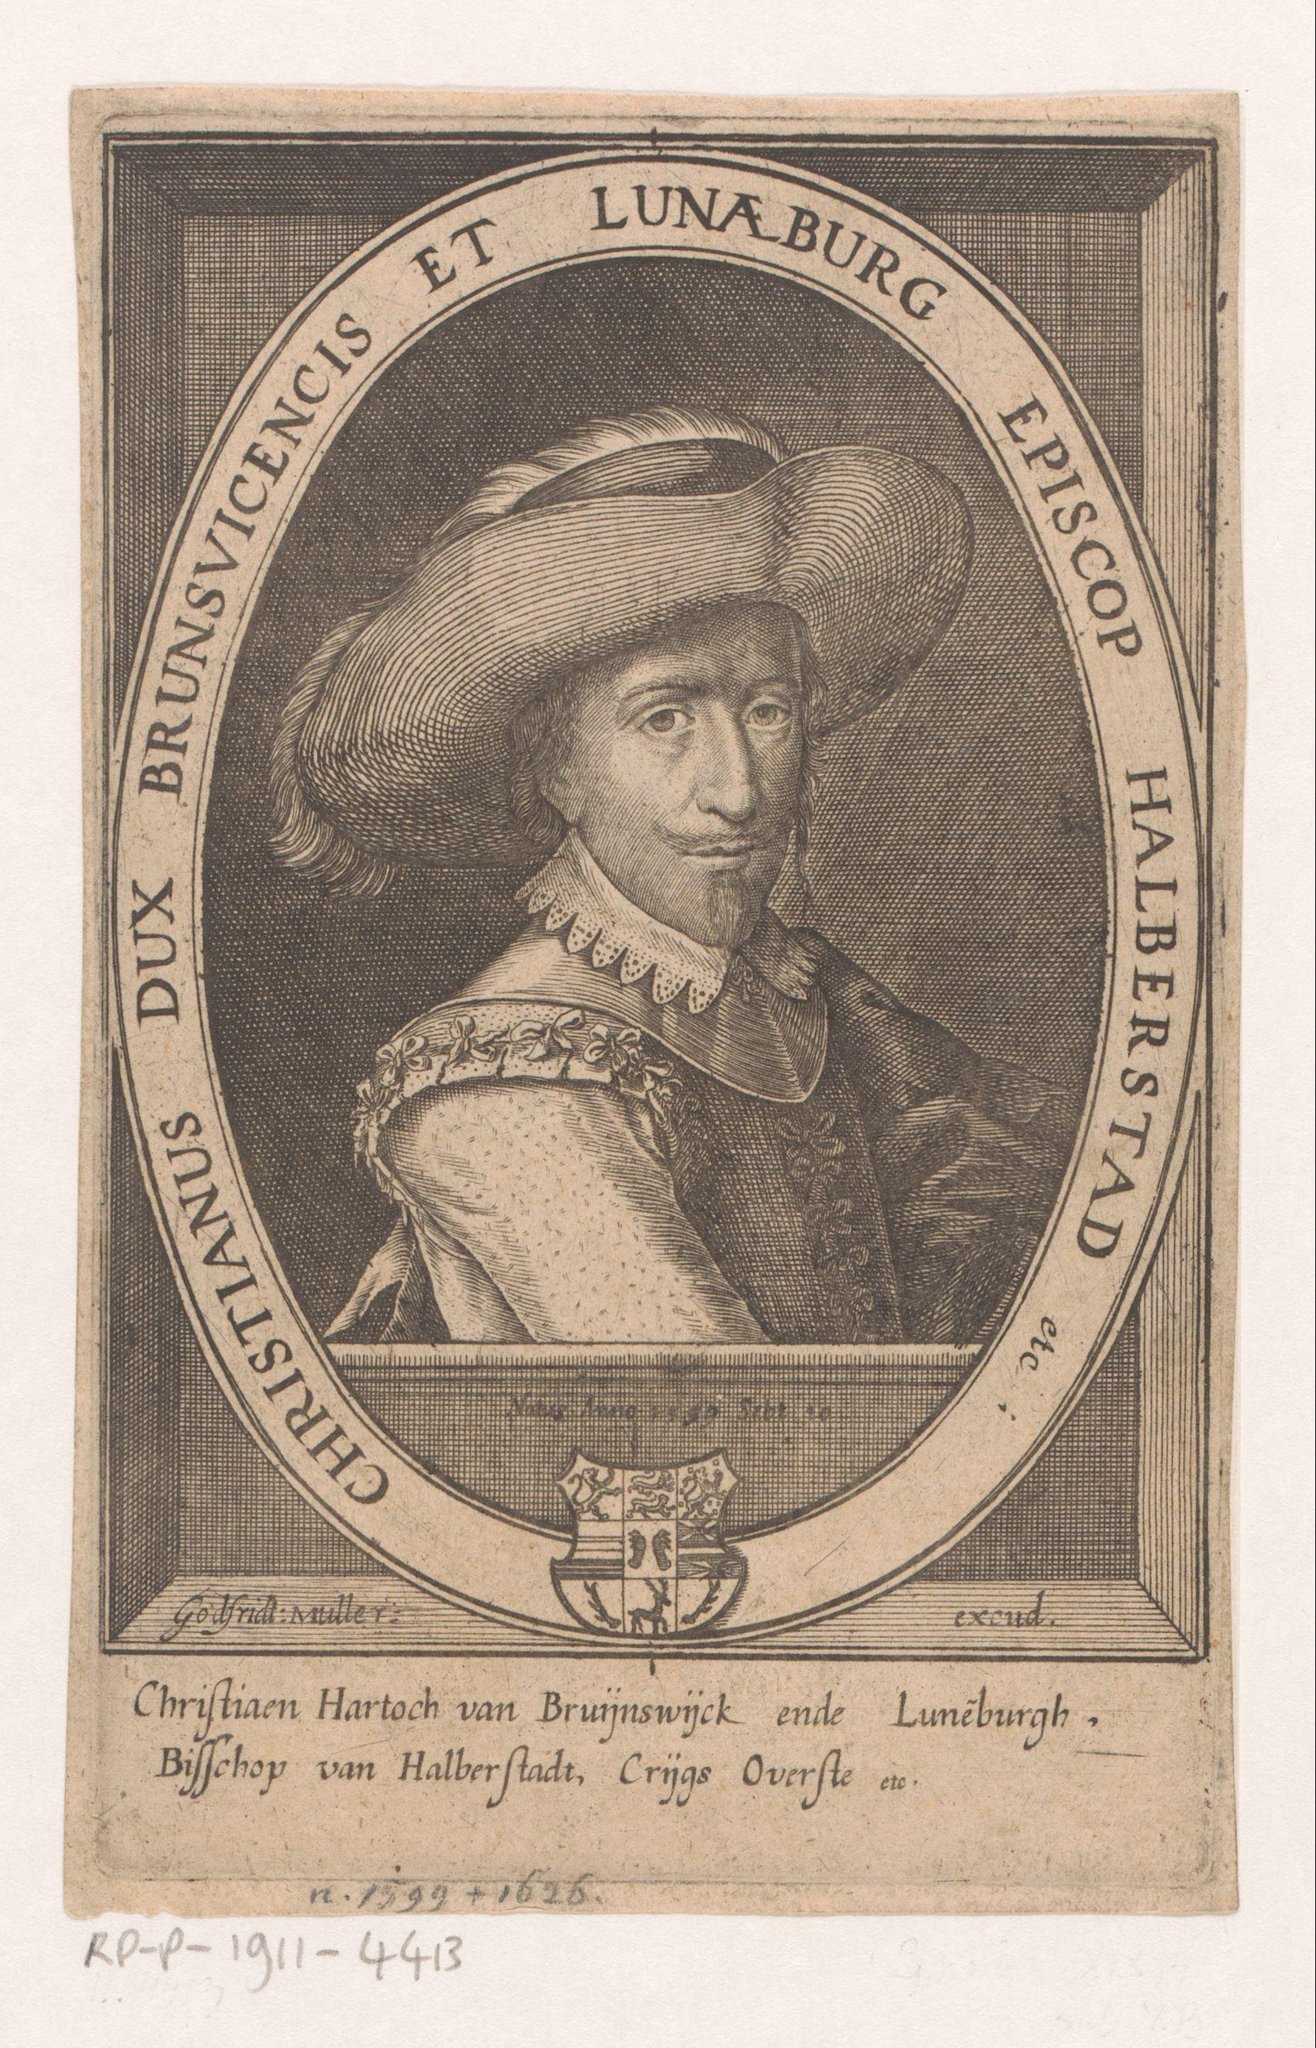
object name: print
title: Portret van Christiaan II van Brunswijk-Wolfenbüttel, bisschop van Halberstadt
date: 1620-1656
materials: paper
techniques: engraving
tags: historical persons, armorial bearing, heraldry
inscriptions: collector's mark: Lugt 2228